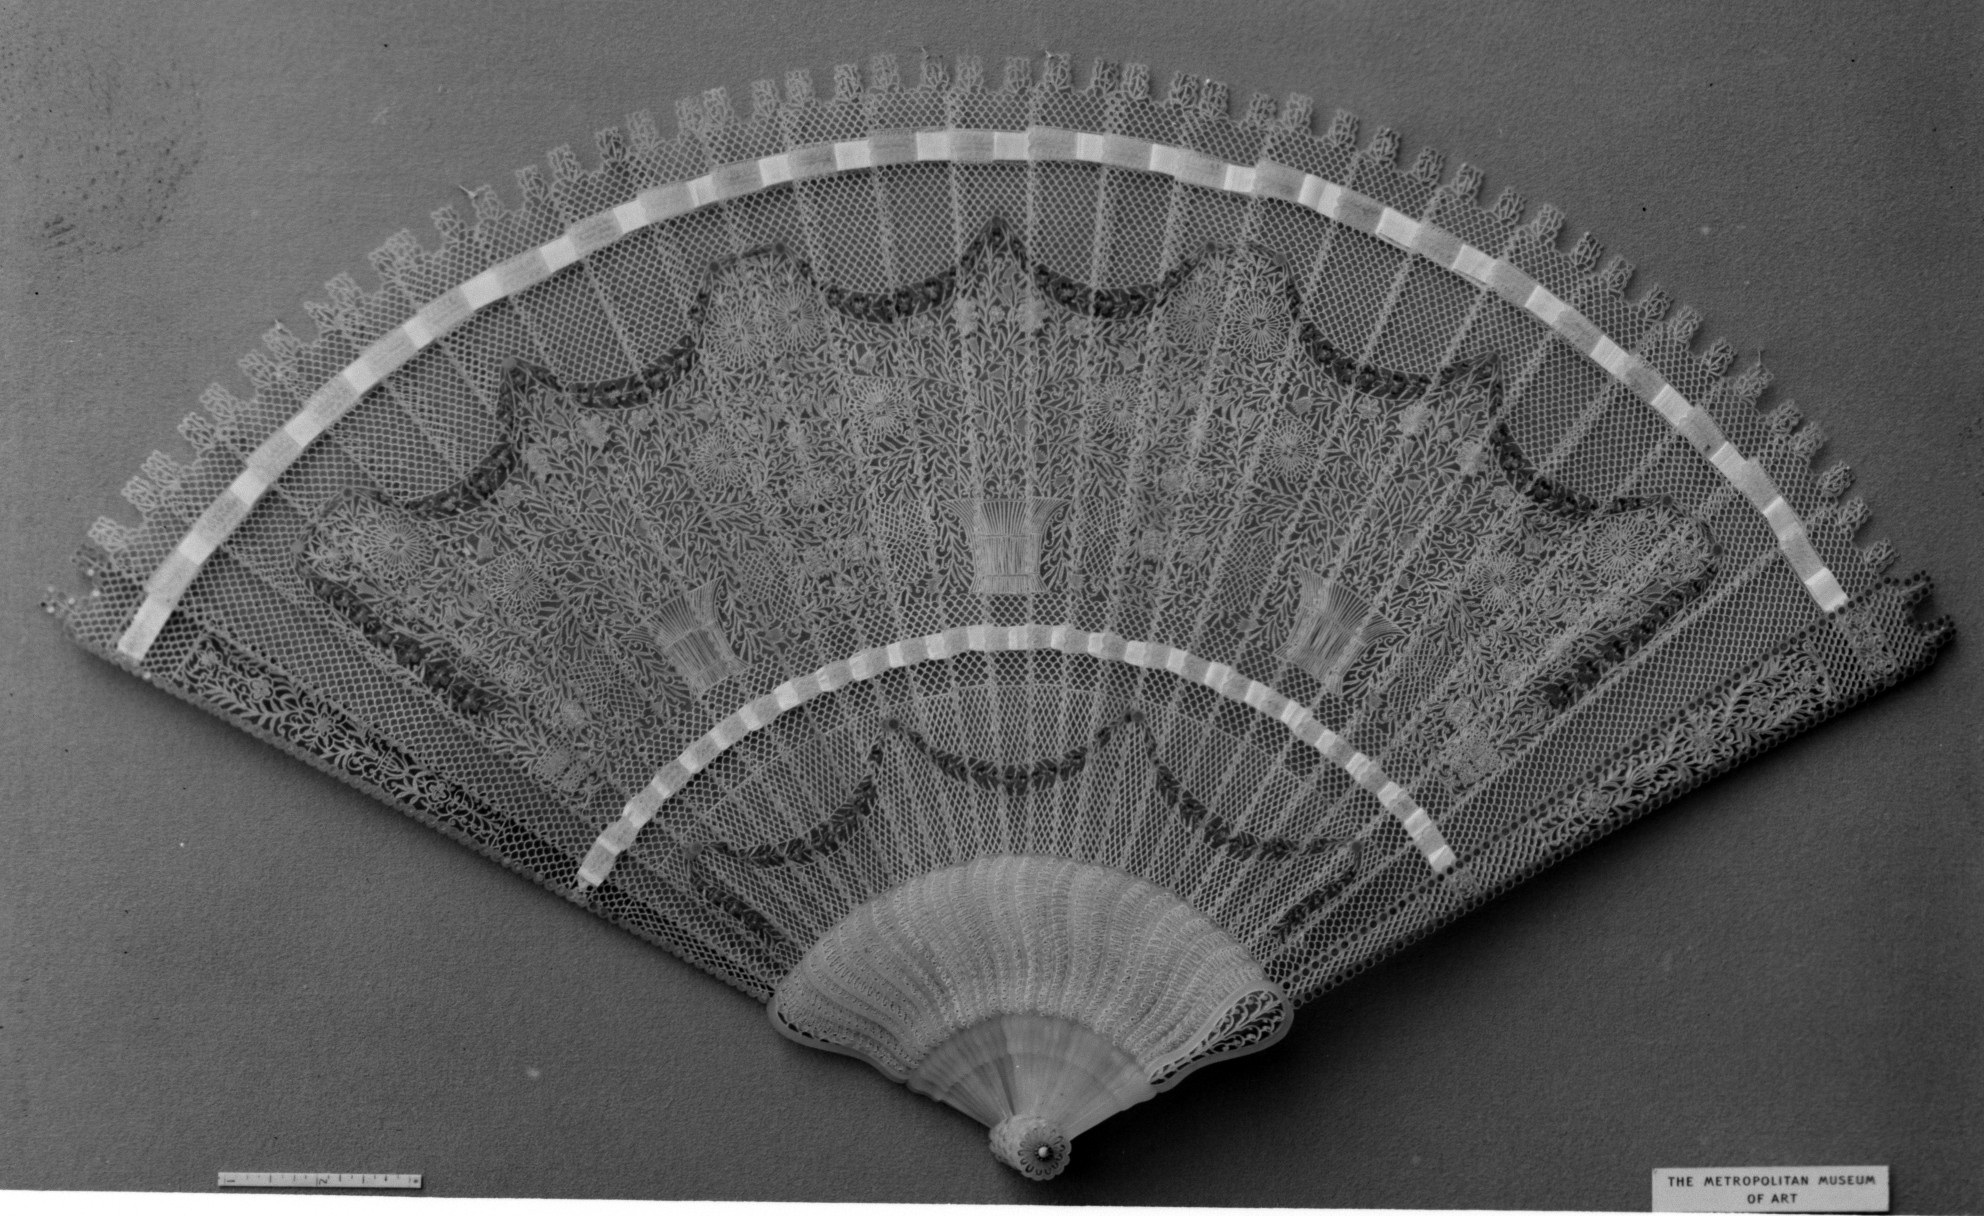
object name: fan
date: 1801-1833